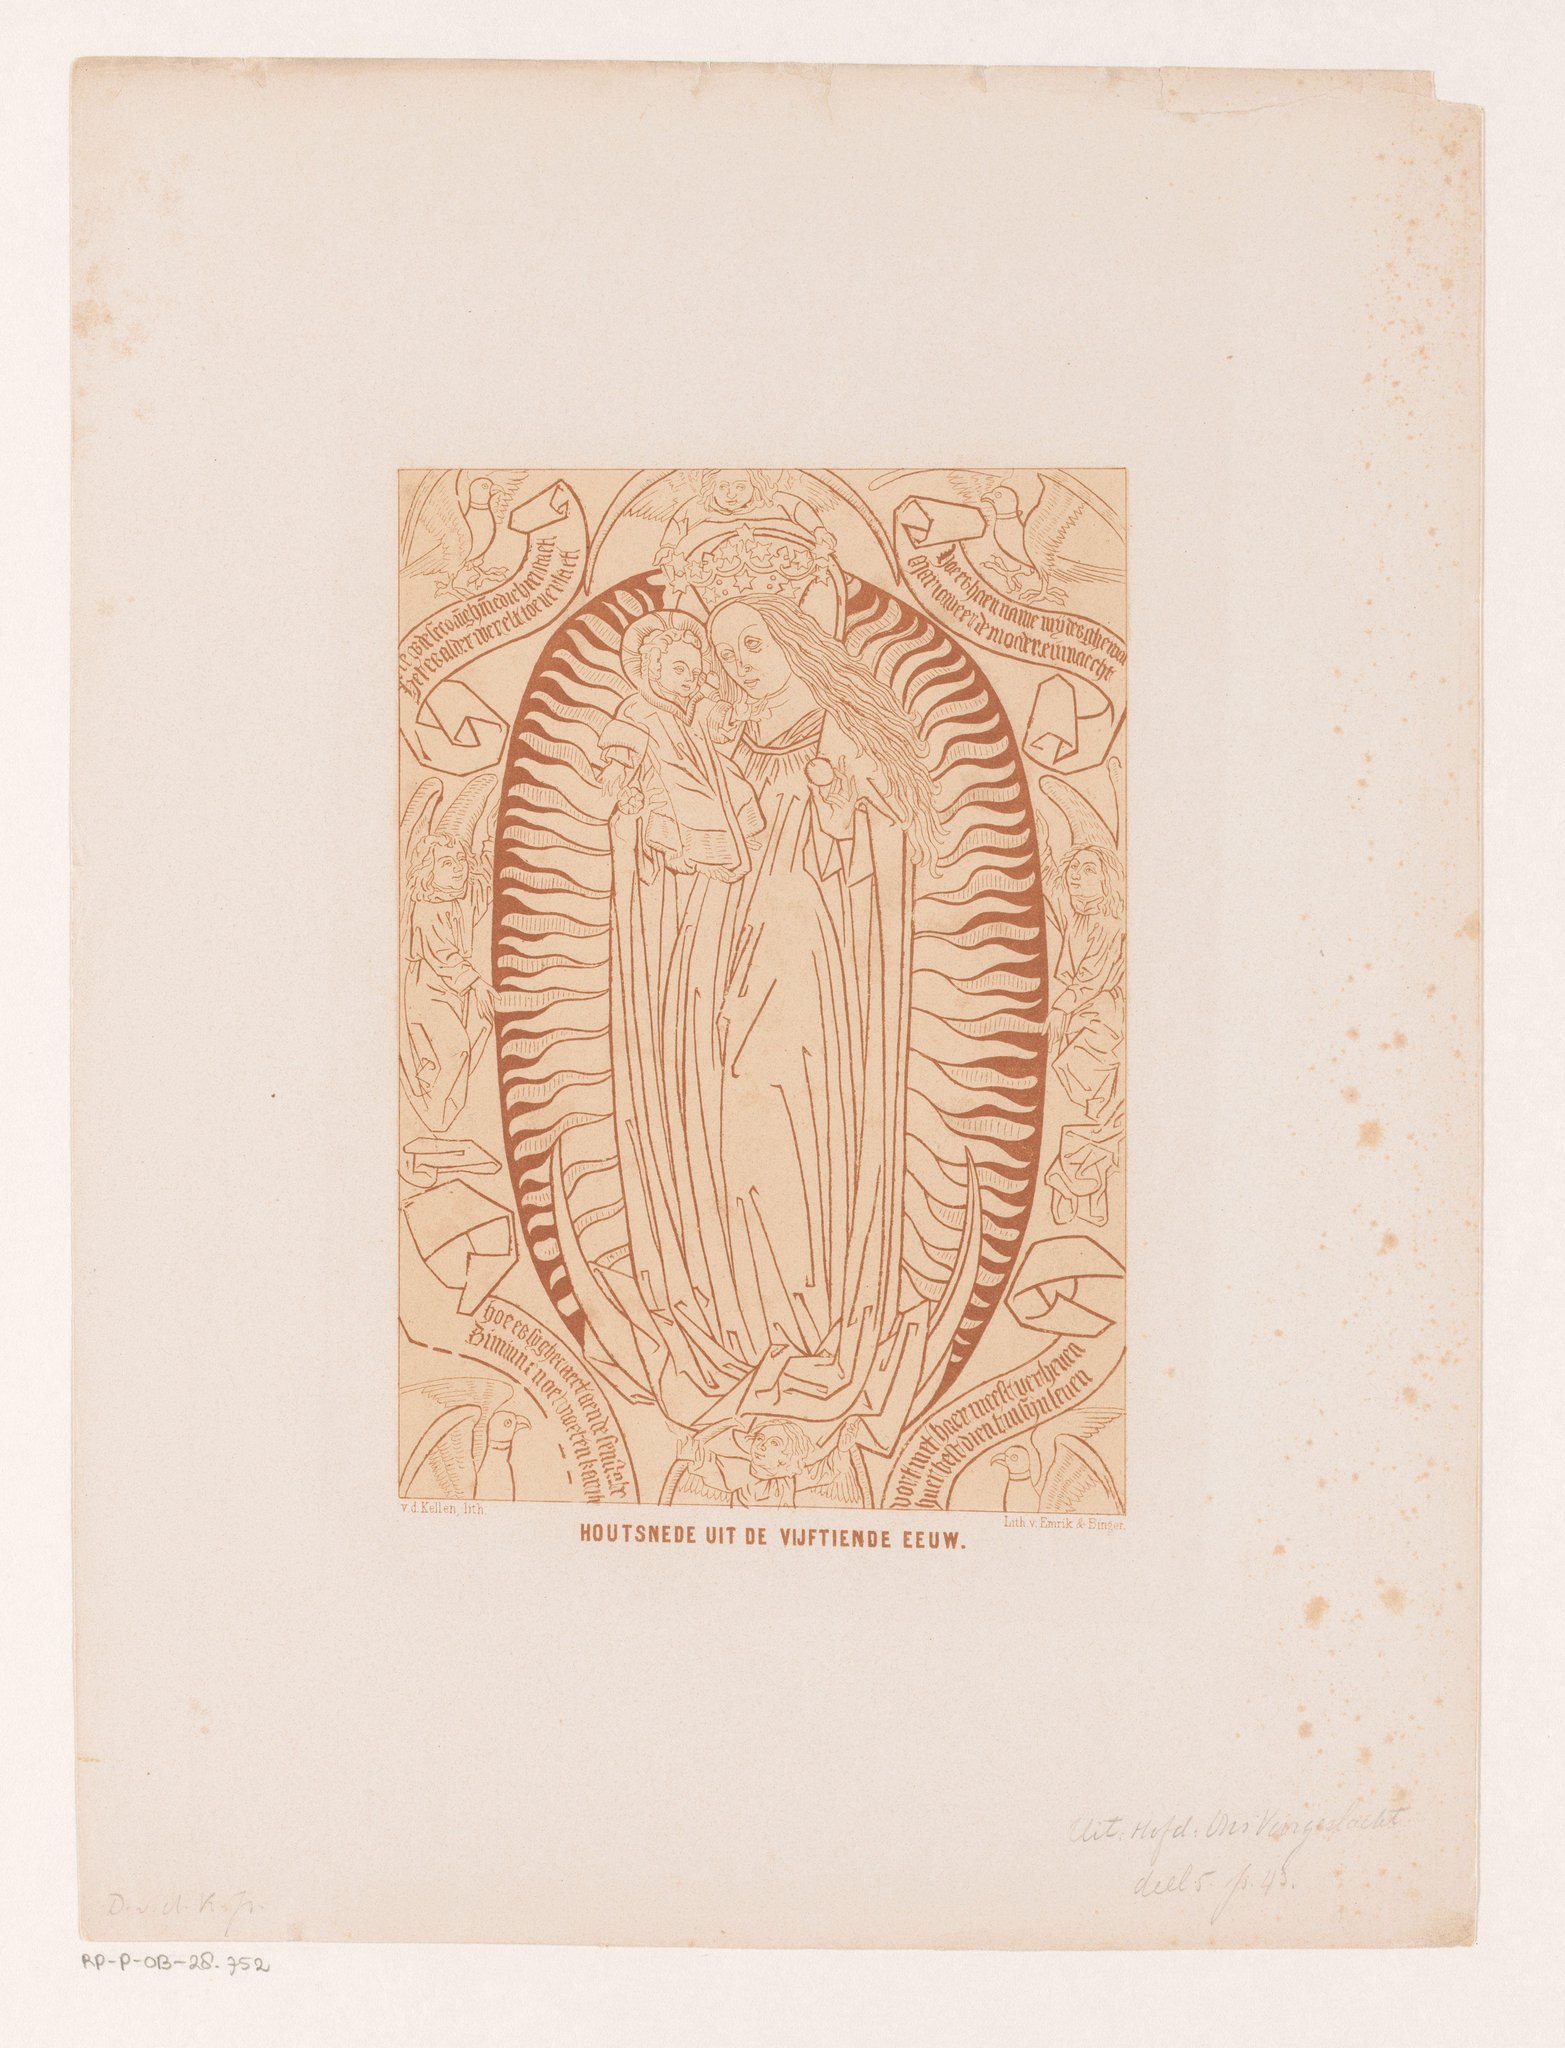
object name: print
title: Houtsnede uit de vijftiende eeuw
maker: david van der kellen (1827-1895)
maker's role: draughtsman, print maker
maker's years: 1827-1895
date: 1859-1864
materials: paper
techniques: tone lithography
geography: haarlem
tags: madonna: mary standing (or half-length), christ-child close to her bosom, mandorla, other birds: dove, holy ghost represented as a dove (in flames)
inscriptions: collector's mark: Lugt 2228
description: Afgebeeld zijn een gekroonde Maria en Christus in een mandorla. Daar omheen engelen, duiven en inscripties.